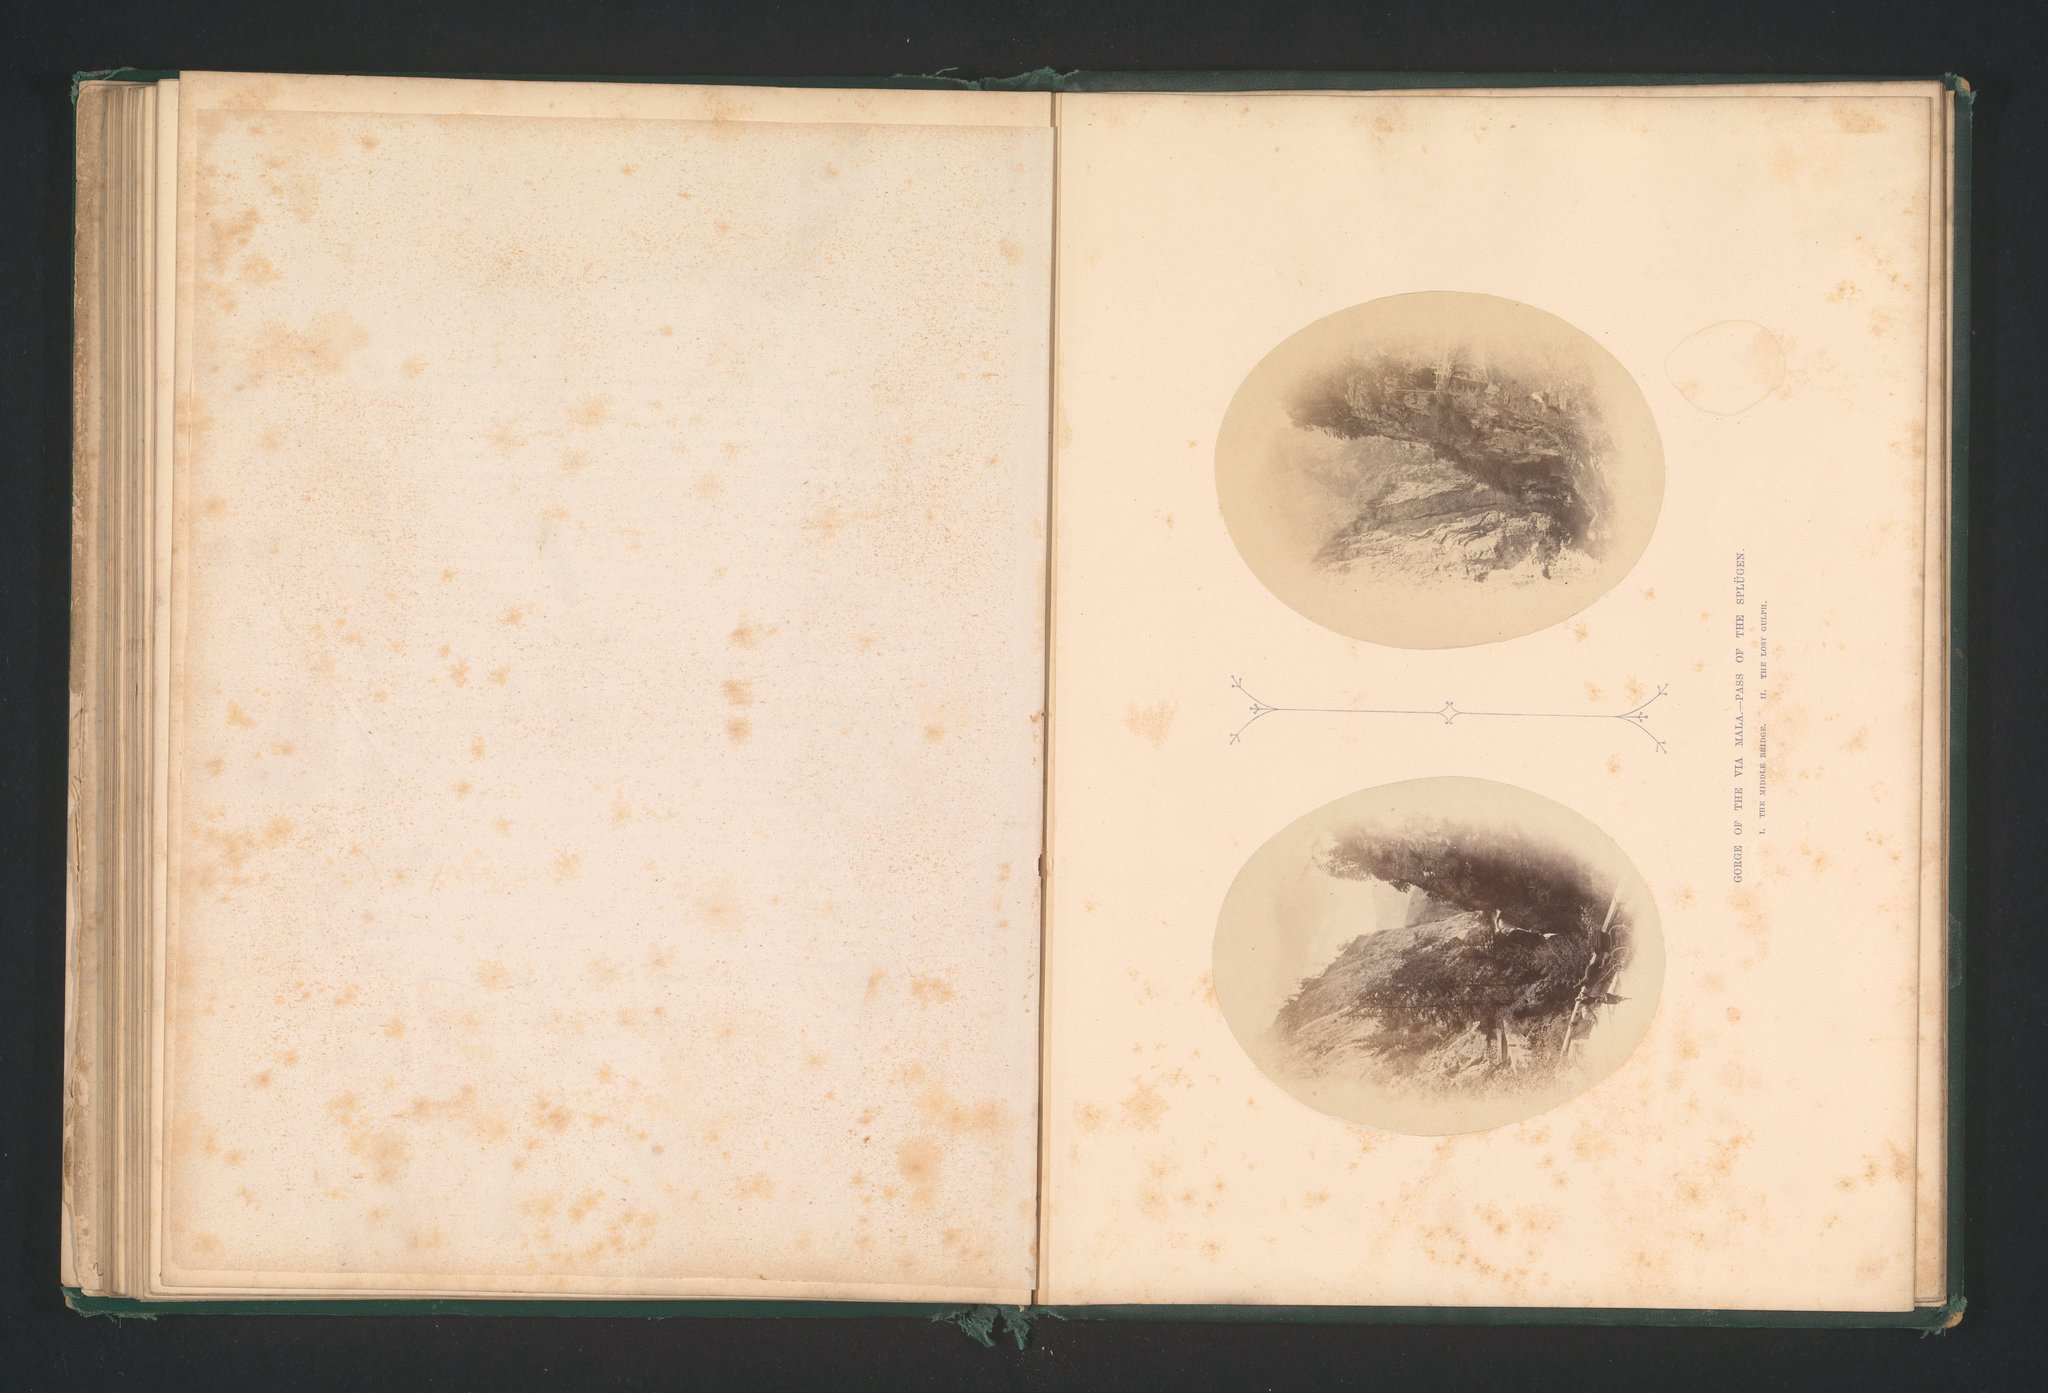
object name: photograph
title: Gezicht op de Via Mala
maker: stephen thompson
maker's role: fotograaf, schrijver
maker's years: 1831-1893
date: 1863-1868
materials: photographic support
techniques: albumen print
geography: graubunden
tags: ravine, chasm, abyss, canyon, road, path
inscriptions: inscription: ‘II. The lost Gulph’